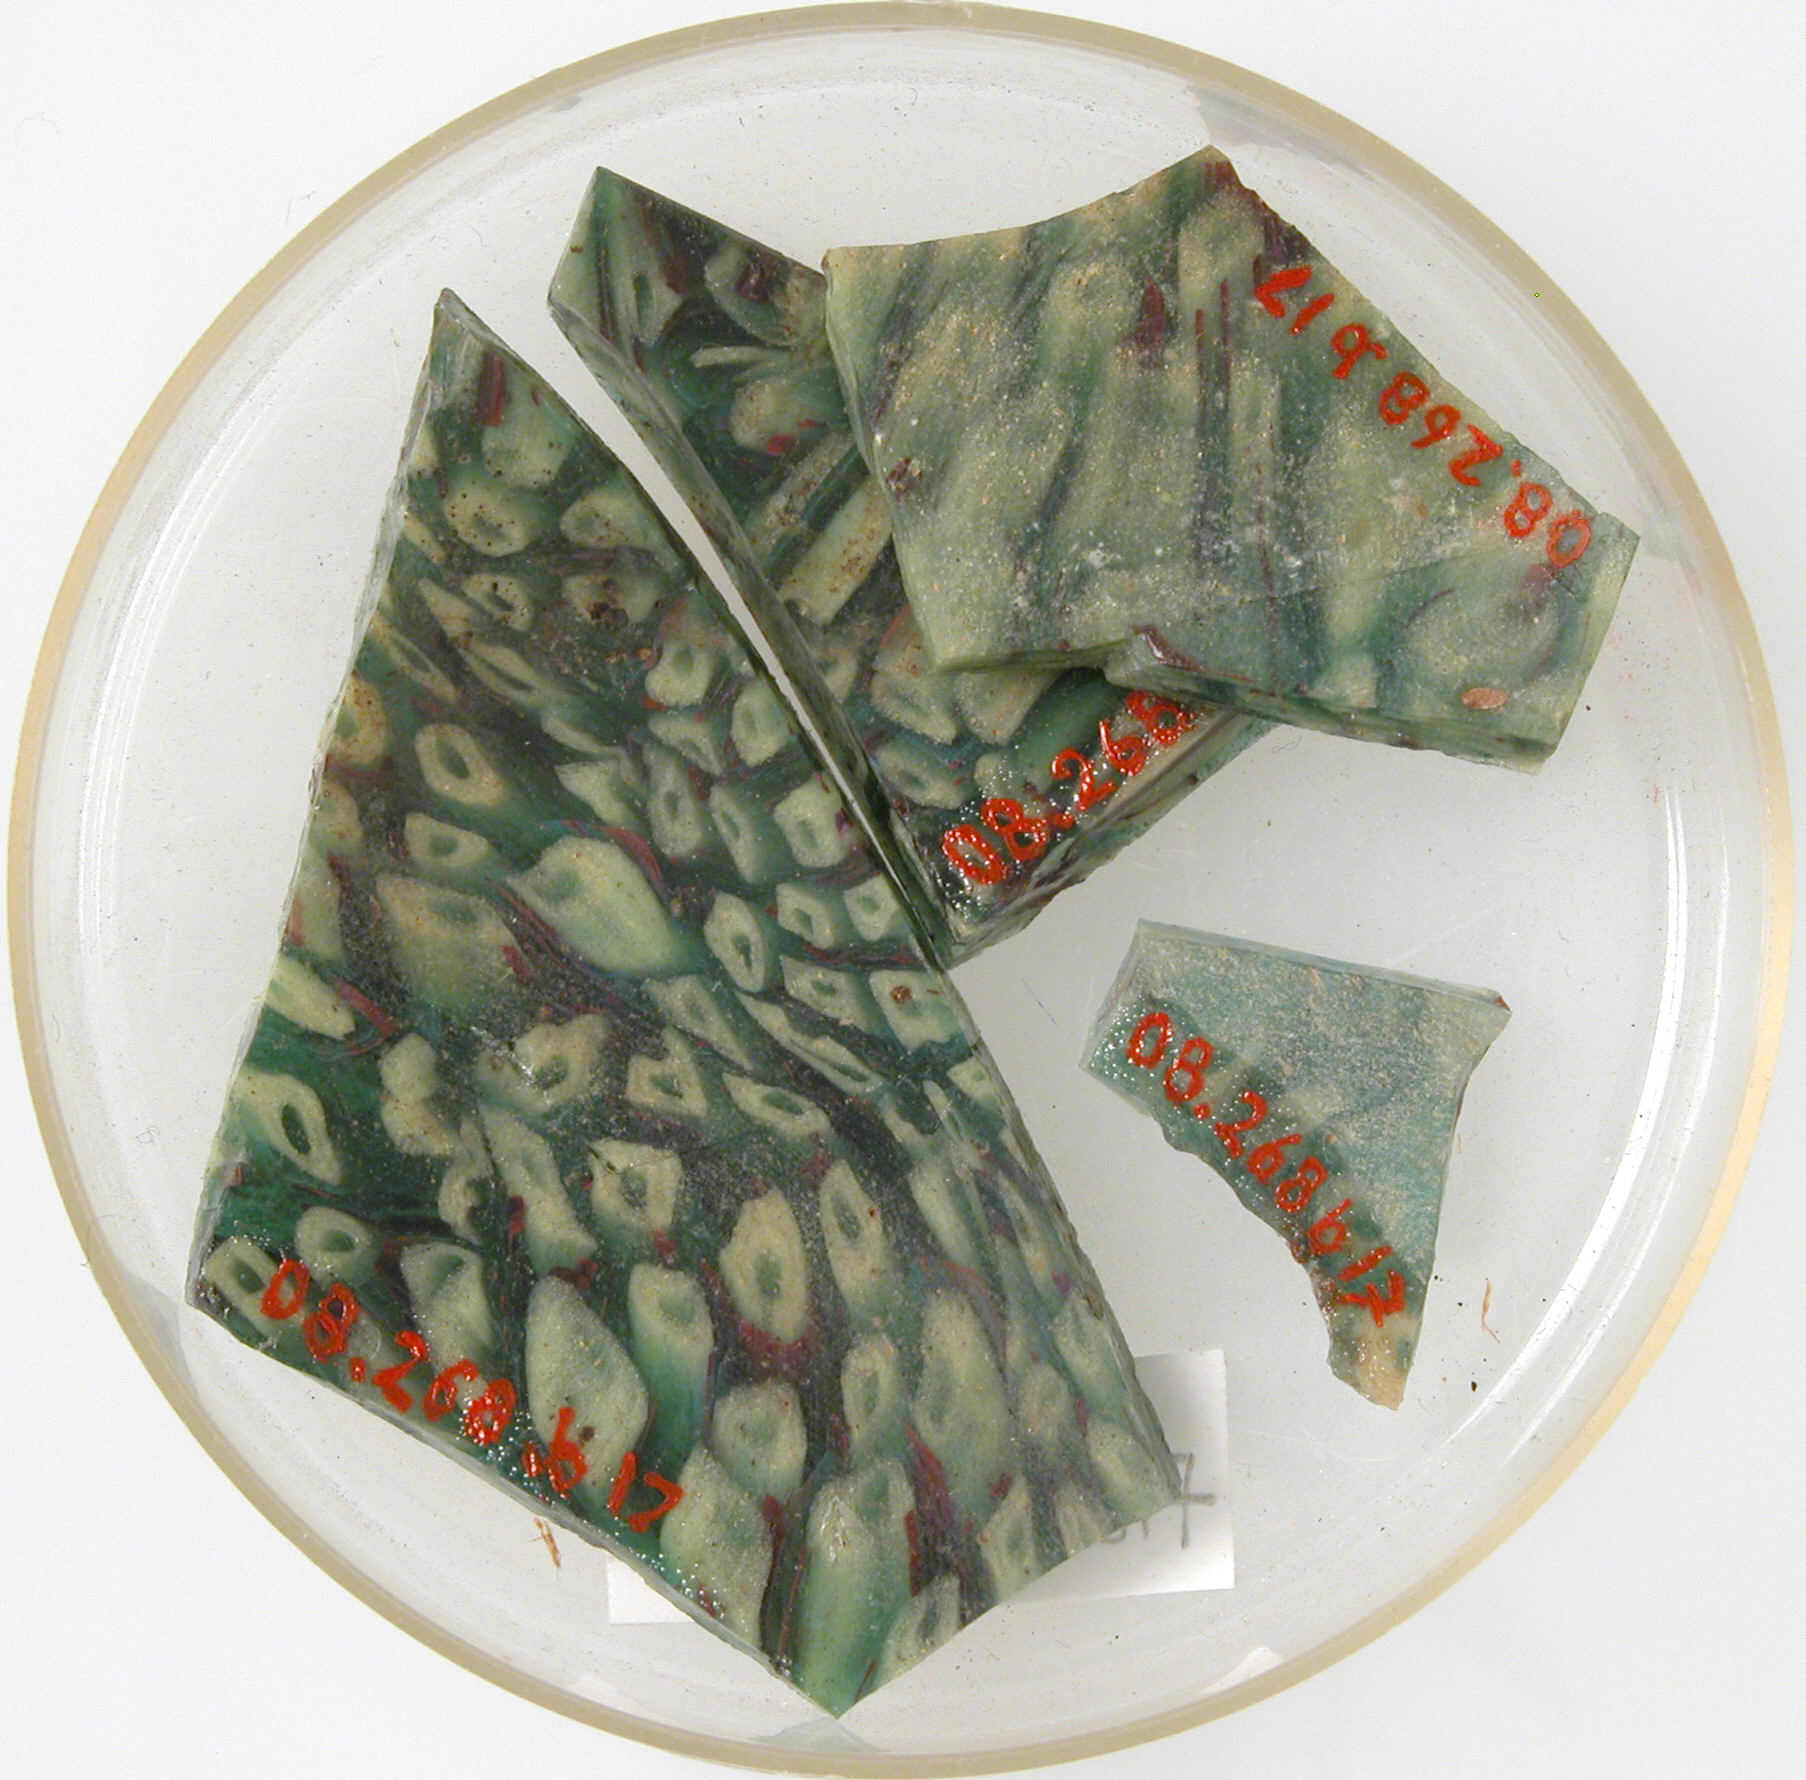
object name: fragment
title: Glass Fragments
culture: coptic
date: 301-433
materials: glass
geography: egypt